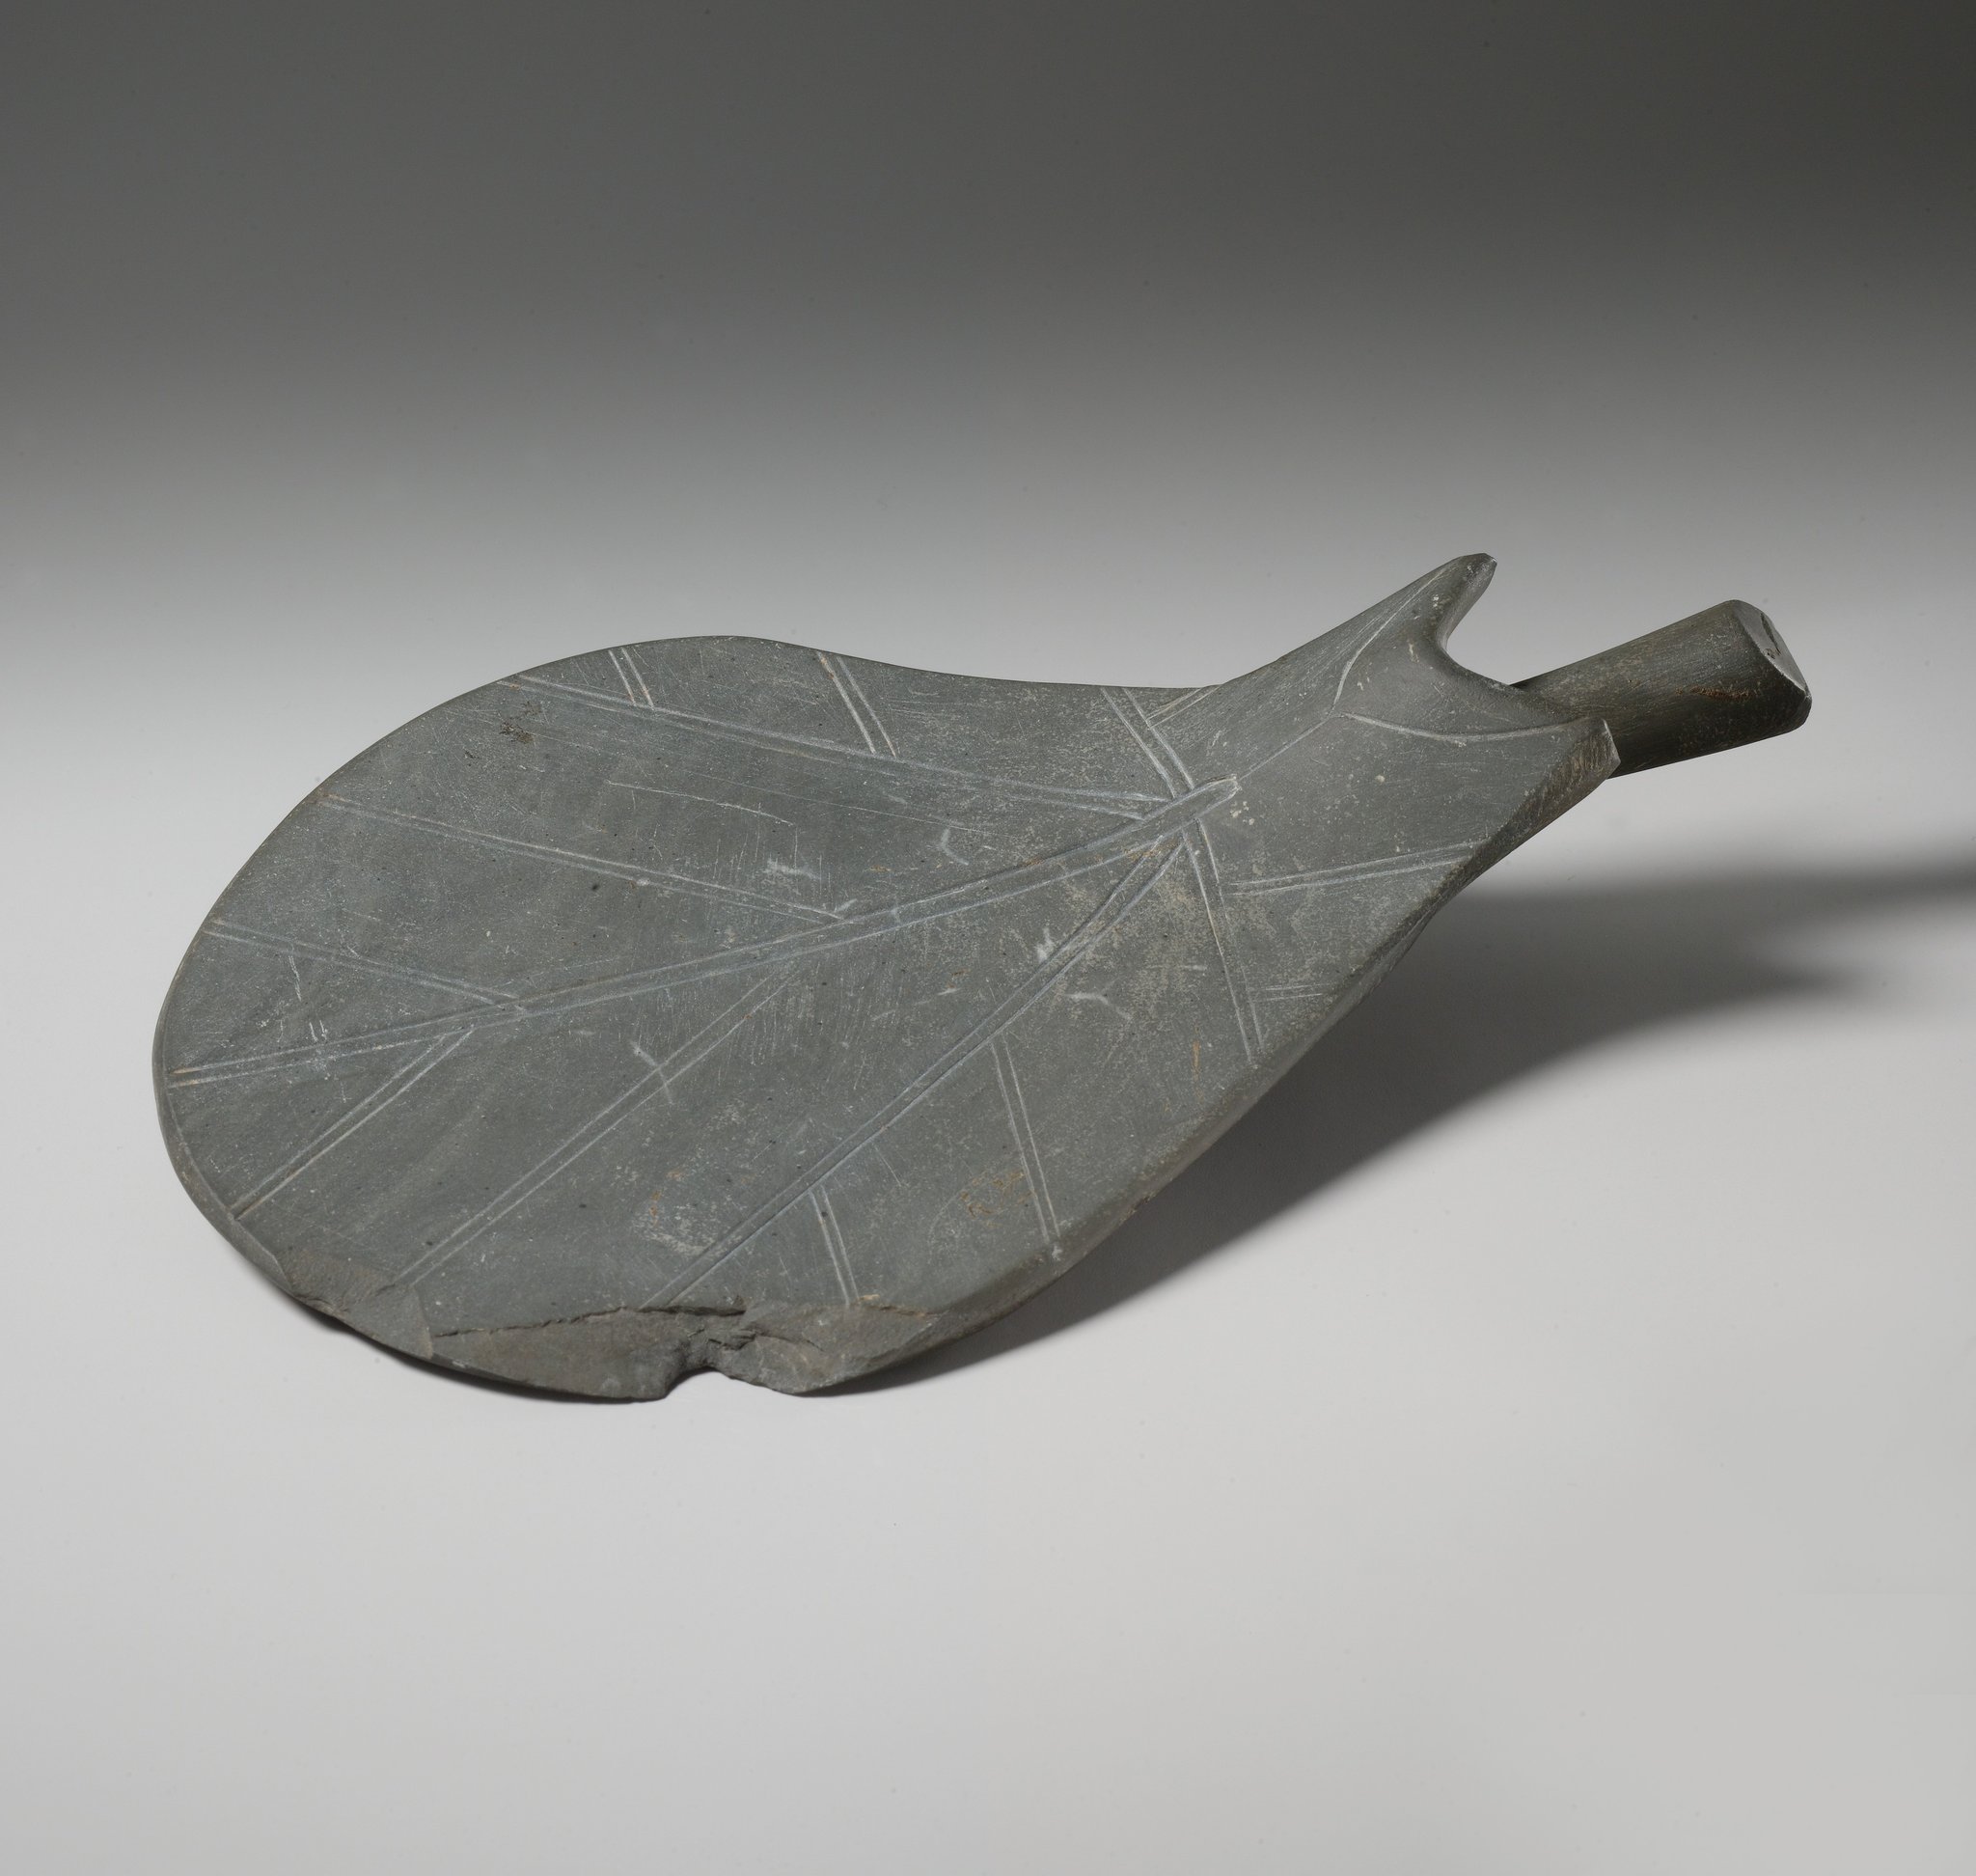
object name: dish, lotus leaf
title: Dish in the shape of a leaf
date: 3100-2900 BCE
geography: egypt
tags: leaves